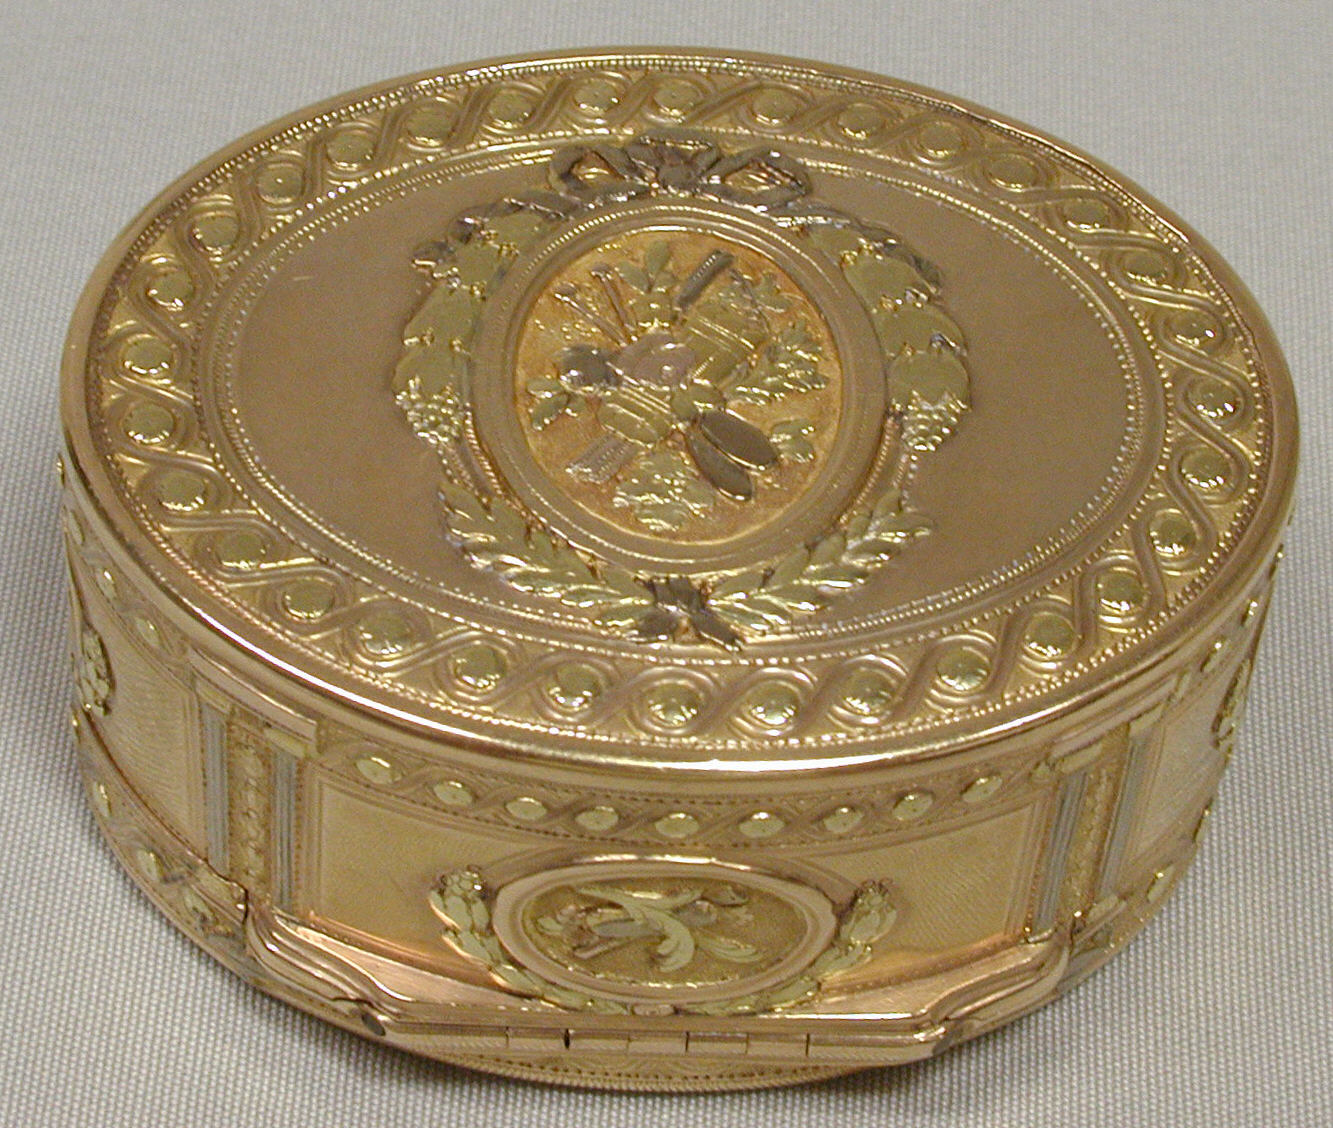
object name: box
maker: pierre-françois-mathis de beaulieu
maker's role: maker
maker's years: 1752-1792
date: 1773-1774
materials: gold